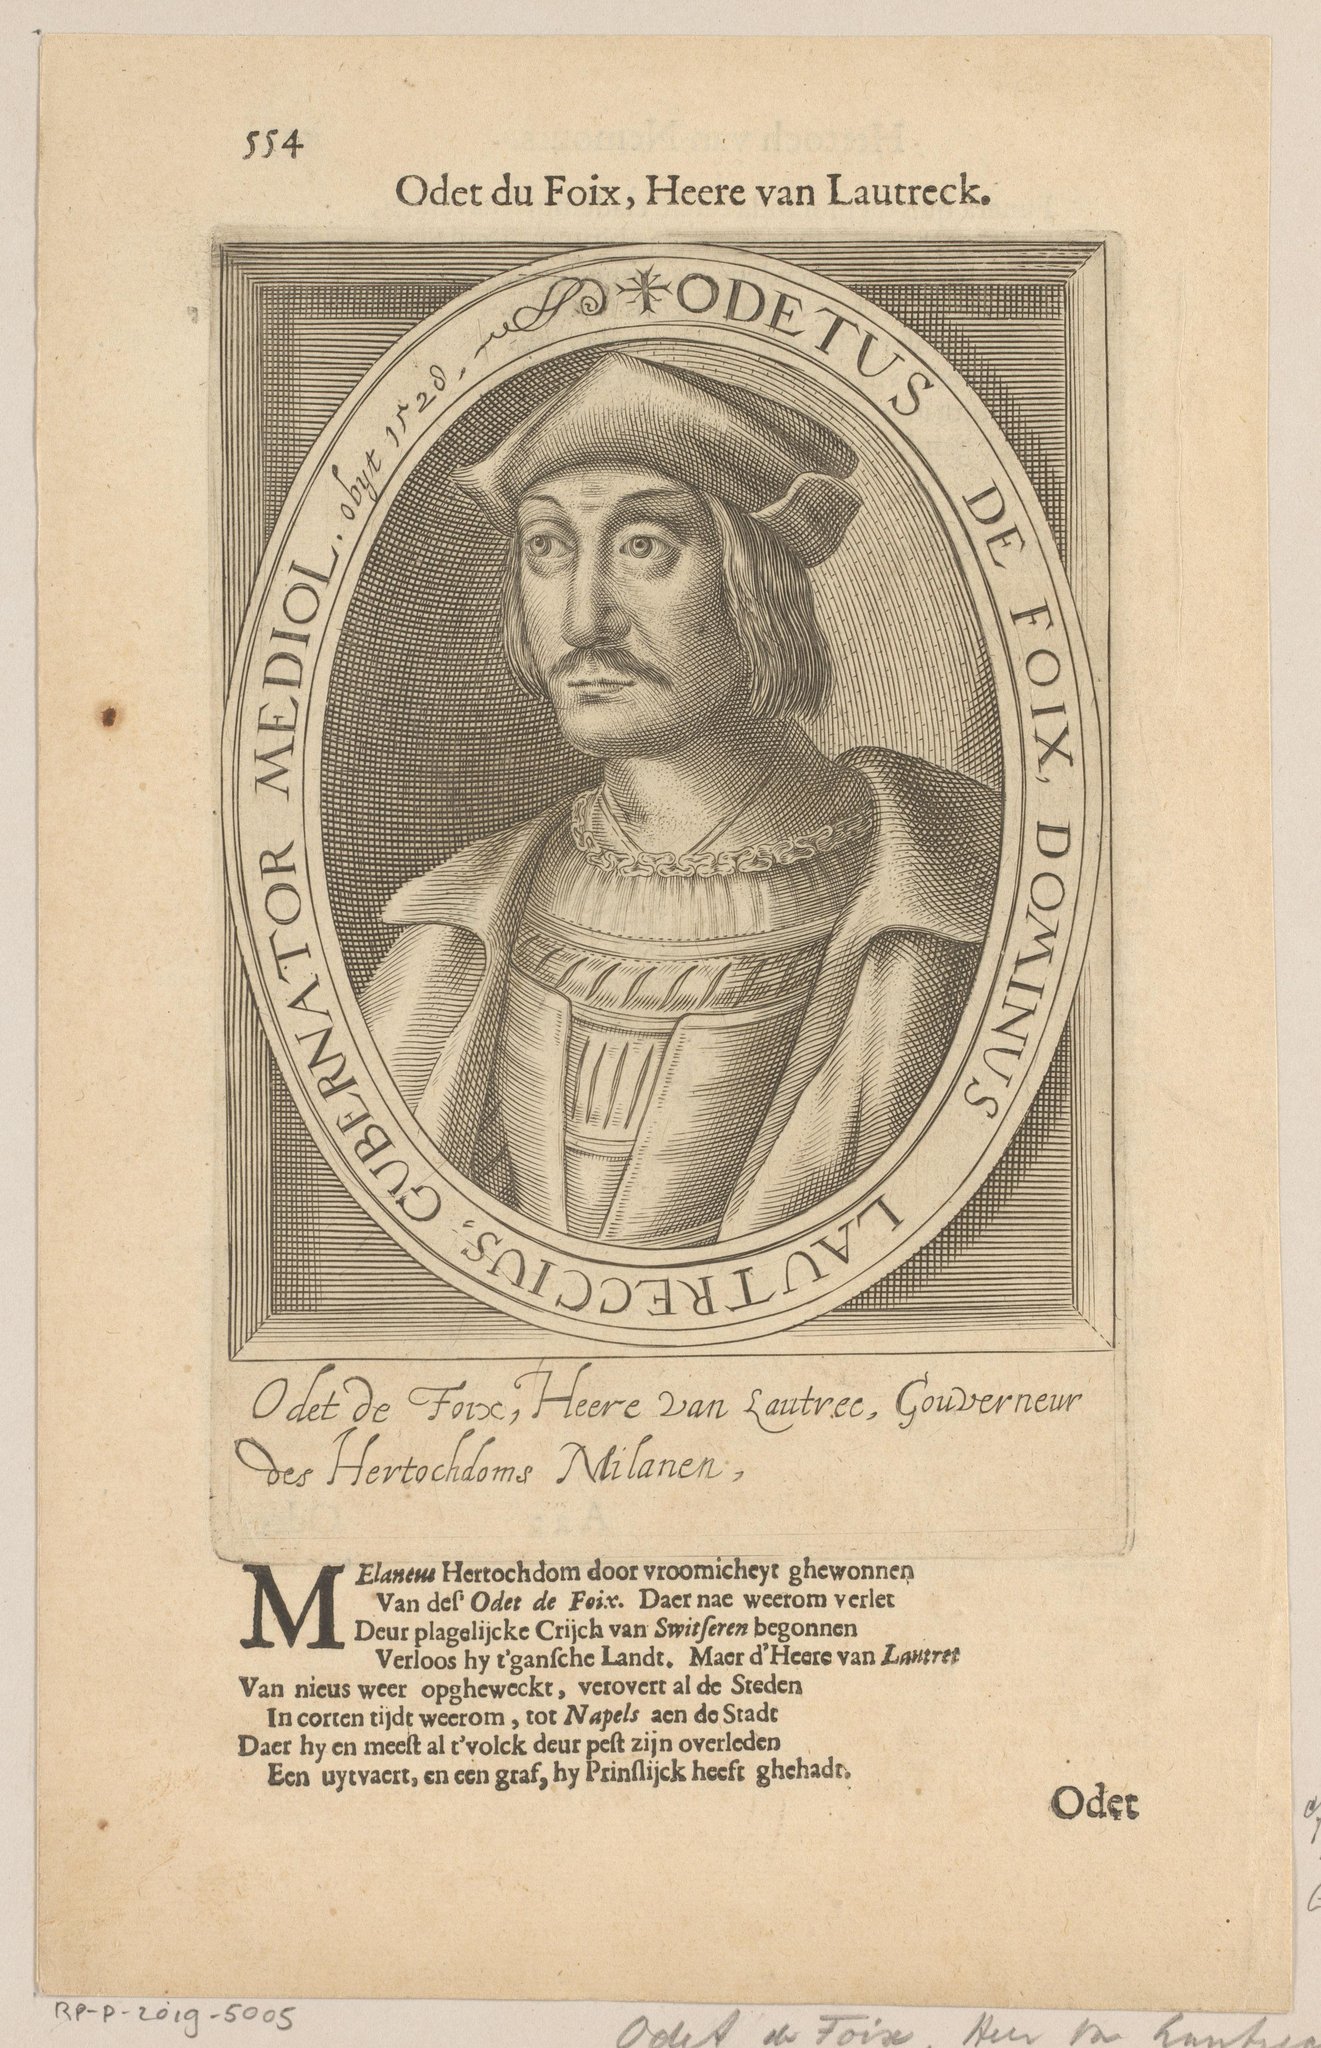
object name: print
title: Portret van Odet de Foix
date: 1617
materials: paper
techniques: engraving, letterpress printing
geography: delft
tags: historical persons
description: Prent uit: Clerck, Nicolaes de. Tooneel der beroemder hertogen, princen, graven ende krygs-helden (...). Delft: Nicolaes de Clerck, 1617.